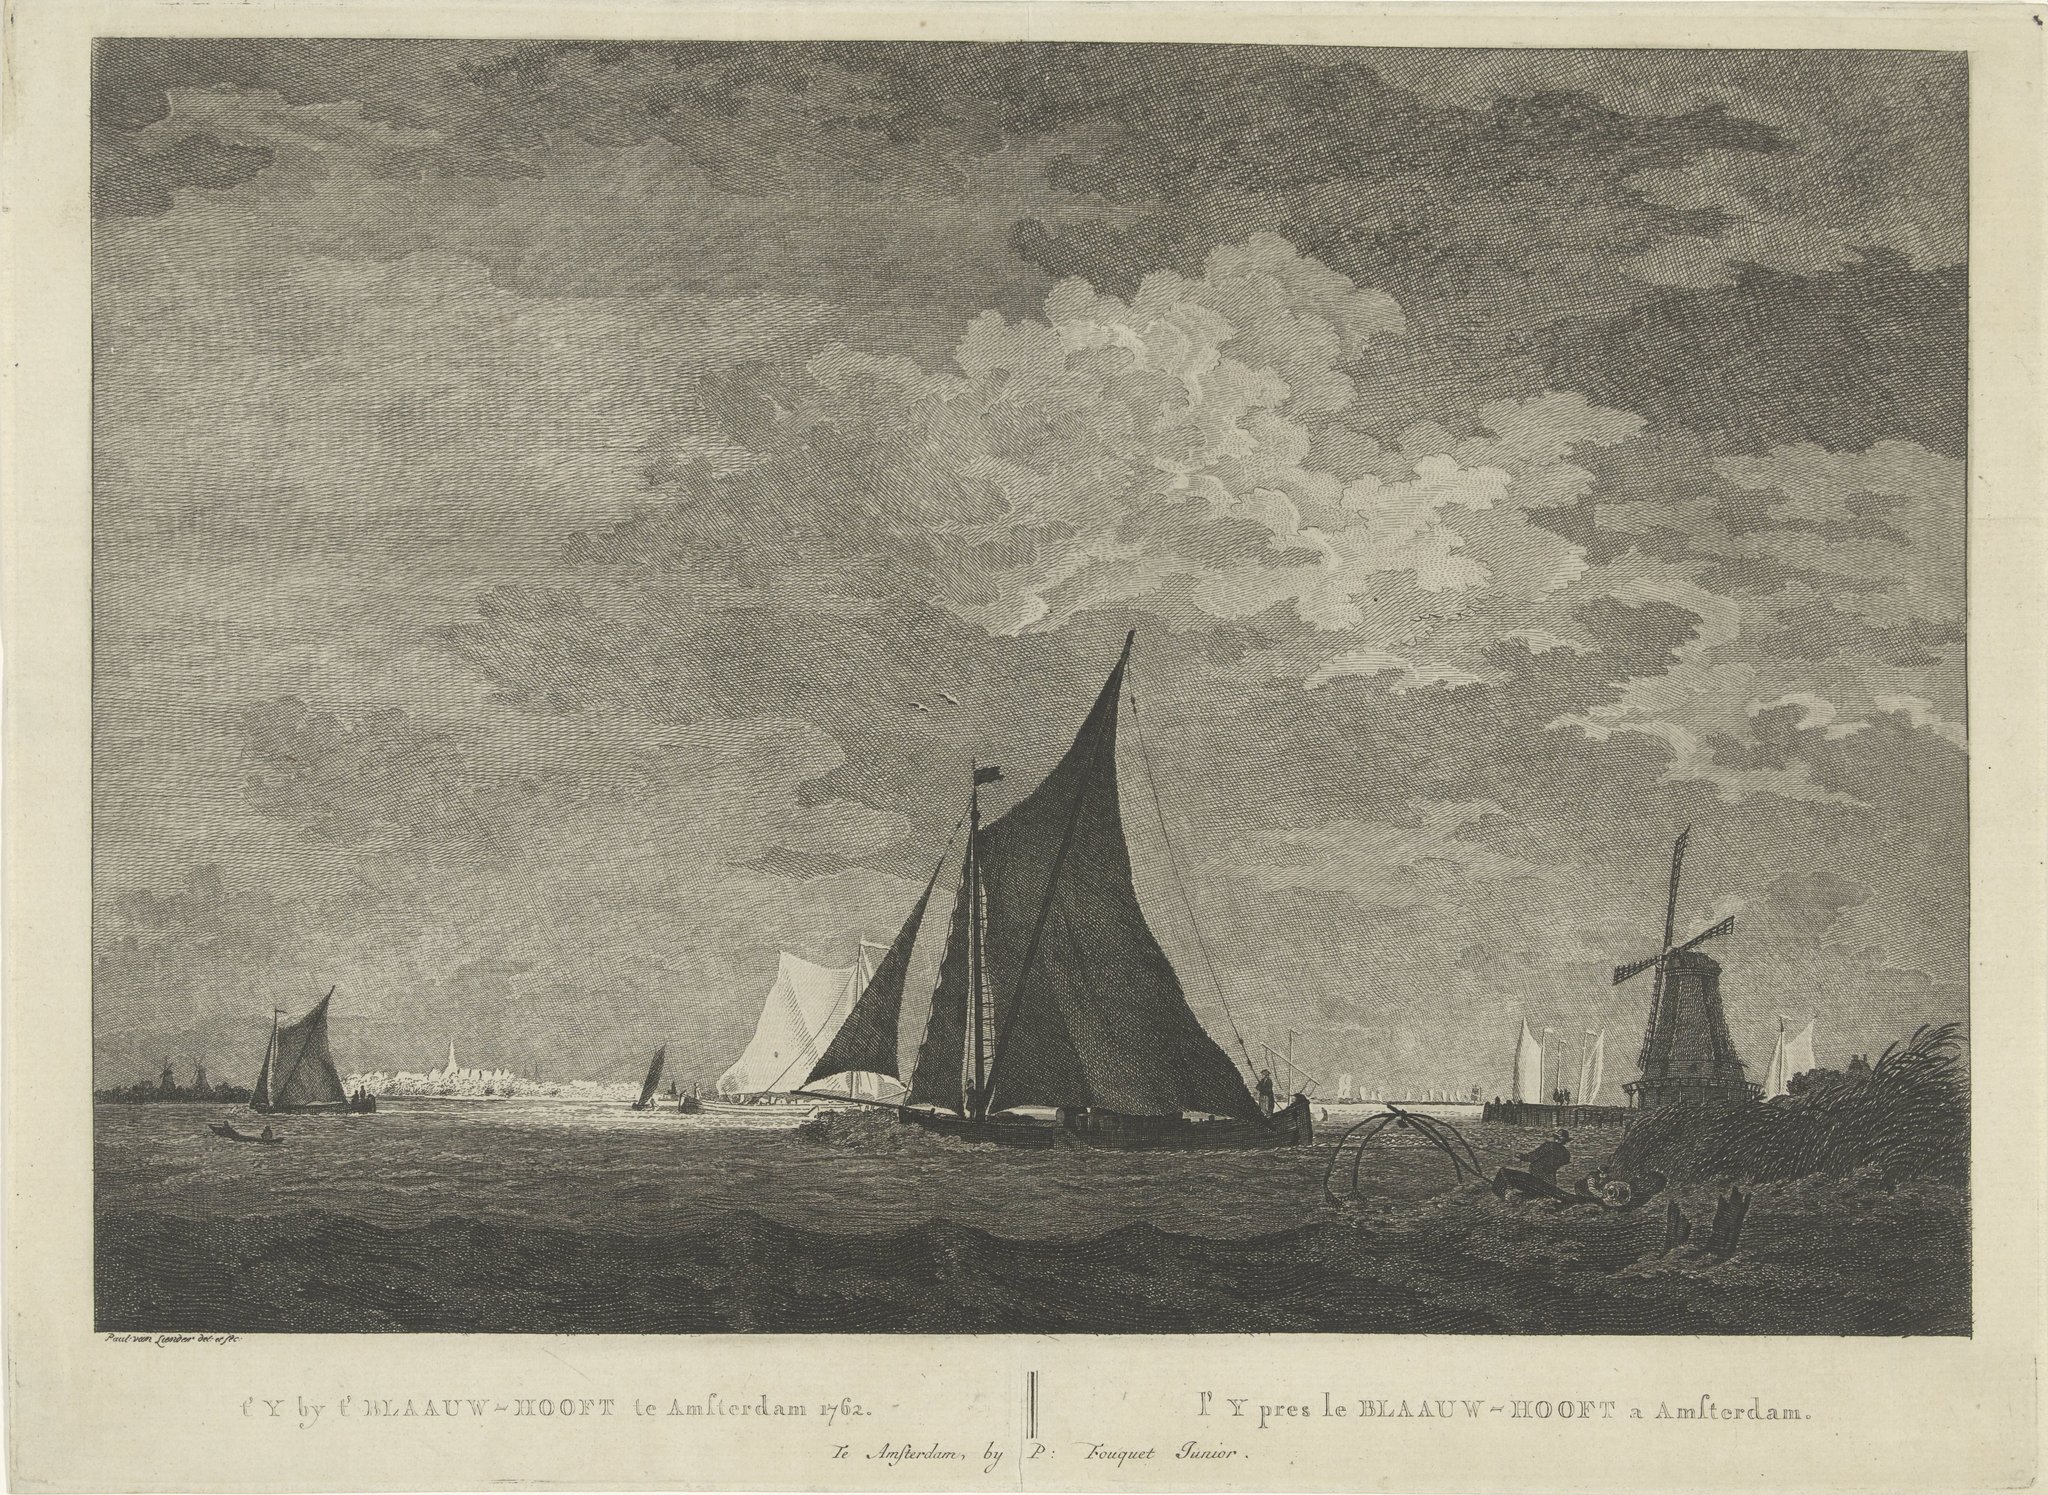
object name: print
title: Schepen op het IJ bij het Blauwhoofd te Amsterdam, 1762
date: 1762-1783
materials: paper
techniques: engraving, etching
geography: amsterdam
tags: sailing-ship, sailing-boat, landscapes with waters, waterscapes, seascapes (in the temperate zone), rowing-boat, canoe, etc., windmill, amsterdam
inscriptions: collector's mark: Lugt 2228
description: Deze prent is ook gebruikt in de zogenaamde Atlas van Fouquet.* Pierre Fouquet gaf vanaf 1760 stadsgezichten van Amsterdam - naar tekeningen van verschillende kunstenaars, gemaakt door verschillende prentmakers - uit. Deze prenten werden aanvankelijk los of in series verkocht. Zoals toen gebruikelijk kon de koper de prenten zelf laten inbinden. Hiertoe gaf Fouquet tussen 1778 en 1783 een titelblad, plattegrond en inhoudsopgave van de tot dusver 100 uitgegeven prenten uit (1). Gezien de inhoud afhankelijk was van wat de koper had verzameld verschilt de inhoud van de verschillende bewaarde Fouquetatlassen onder deze titel sterk. Ook zijn er exemplaren bekend waar tevens andere prenten aan zijn toegevoegd. Omdat er behoefte bleek aan uitleg bij de platen werd in 1783 een nieuwe versie van de atlas uitgegeven, aangevuld met tekst en twee prenten. De aangegeven volgorde veranderde maar de platen van de al eerder uitgegeven prenten bleven ongewijzigd. Deze uitgave werd in opdracht van Fouquet gedrukt bij Daniël Jean Changuion en Petrus den Hengst (2). Een tiental platen werd bijgewerkt en verscheen, met nieuw impressum, in het vervolg van Wagenaars geschiedenis van Amsterdam, uitgeven door Petrus Conradi en Folkert van der Plaats (3). Een aantal jaar na het overlijden van Fouquet kwam Evert Maaskamp met een nieuwe uitgave van de atlas, met verbeterde tekst en toevoeging van twee prenten. Op alle platen verwijderde hij het oude en liet hij zijn eigen impressum zetten (4). De huidige staat van de prent komt waarschijnlijk voor in exemplaren van de onder (1) en (2) genoemde werken. * Onder de Atlas van Fouquet of Fouquetatlas verstaan we de hieronder vermelde publicaties (1), (2) en (4). (1). Afbeeldingen van de wyd-vermaarde koopstad Amsterdam benevens des zelvs voornaamste gebouwen en gezigten alle naar het leeven getekend / Receuil des edifices les plus considerables et des plus belles vues, de la fameuse ville d'Amsterdam, dessinées d'après nature. Amsterdam: Pierre Fouquet, 1778-1783. (2). Nieuwe atlas, van de voornaamste gebouwen en gezigten der stad Amsterdam, met derzelver beknopte beschryvingen. 2 delen. Amsterdam: Daniël Jean Changuion en Petrus den Hengst [in opdracht van Pierre Fouquet], 1783. (3). Stijl, Simon. Amsterdam, in zyne geschiedenissen, voorregten, koophandel, gebouwen, kerkenstaat, schoolen, schutterye, gilden en regeeringe, beschreeven. Om te dienen ten vervolge op het werk van Jan Wagenaar (…). 10 delen. Amsterdam en Harlingen: Petrus Conradi en Folkert van der Plaats, 1788-1801. (4). Nieuwe atlas, van de voornaamste gebouwen en gezigten der stad Amsterdam. Met derzelver beknopte beschryvingen. Amsterdam: Evert Maaskamp, 1805. * Het aantal vermelde staten is gebaseerd op het aantal gevonden staten. Mogelijk zijn er meer staten van deze prent. Voor tweede bekende staat zie RP-P-OB-46.343. Voor vierde bekende staat zie RP-P-AO-20-80A.